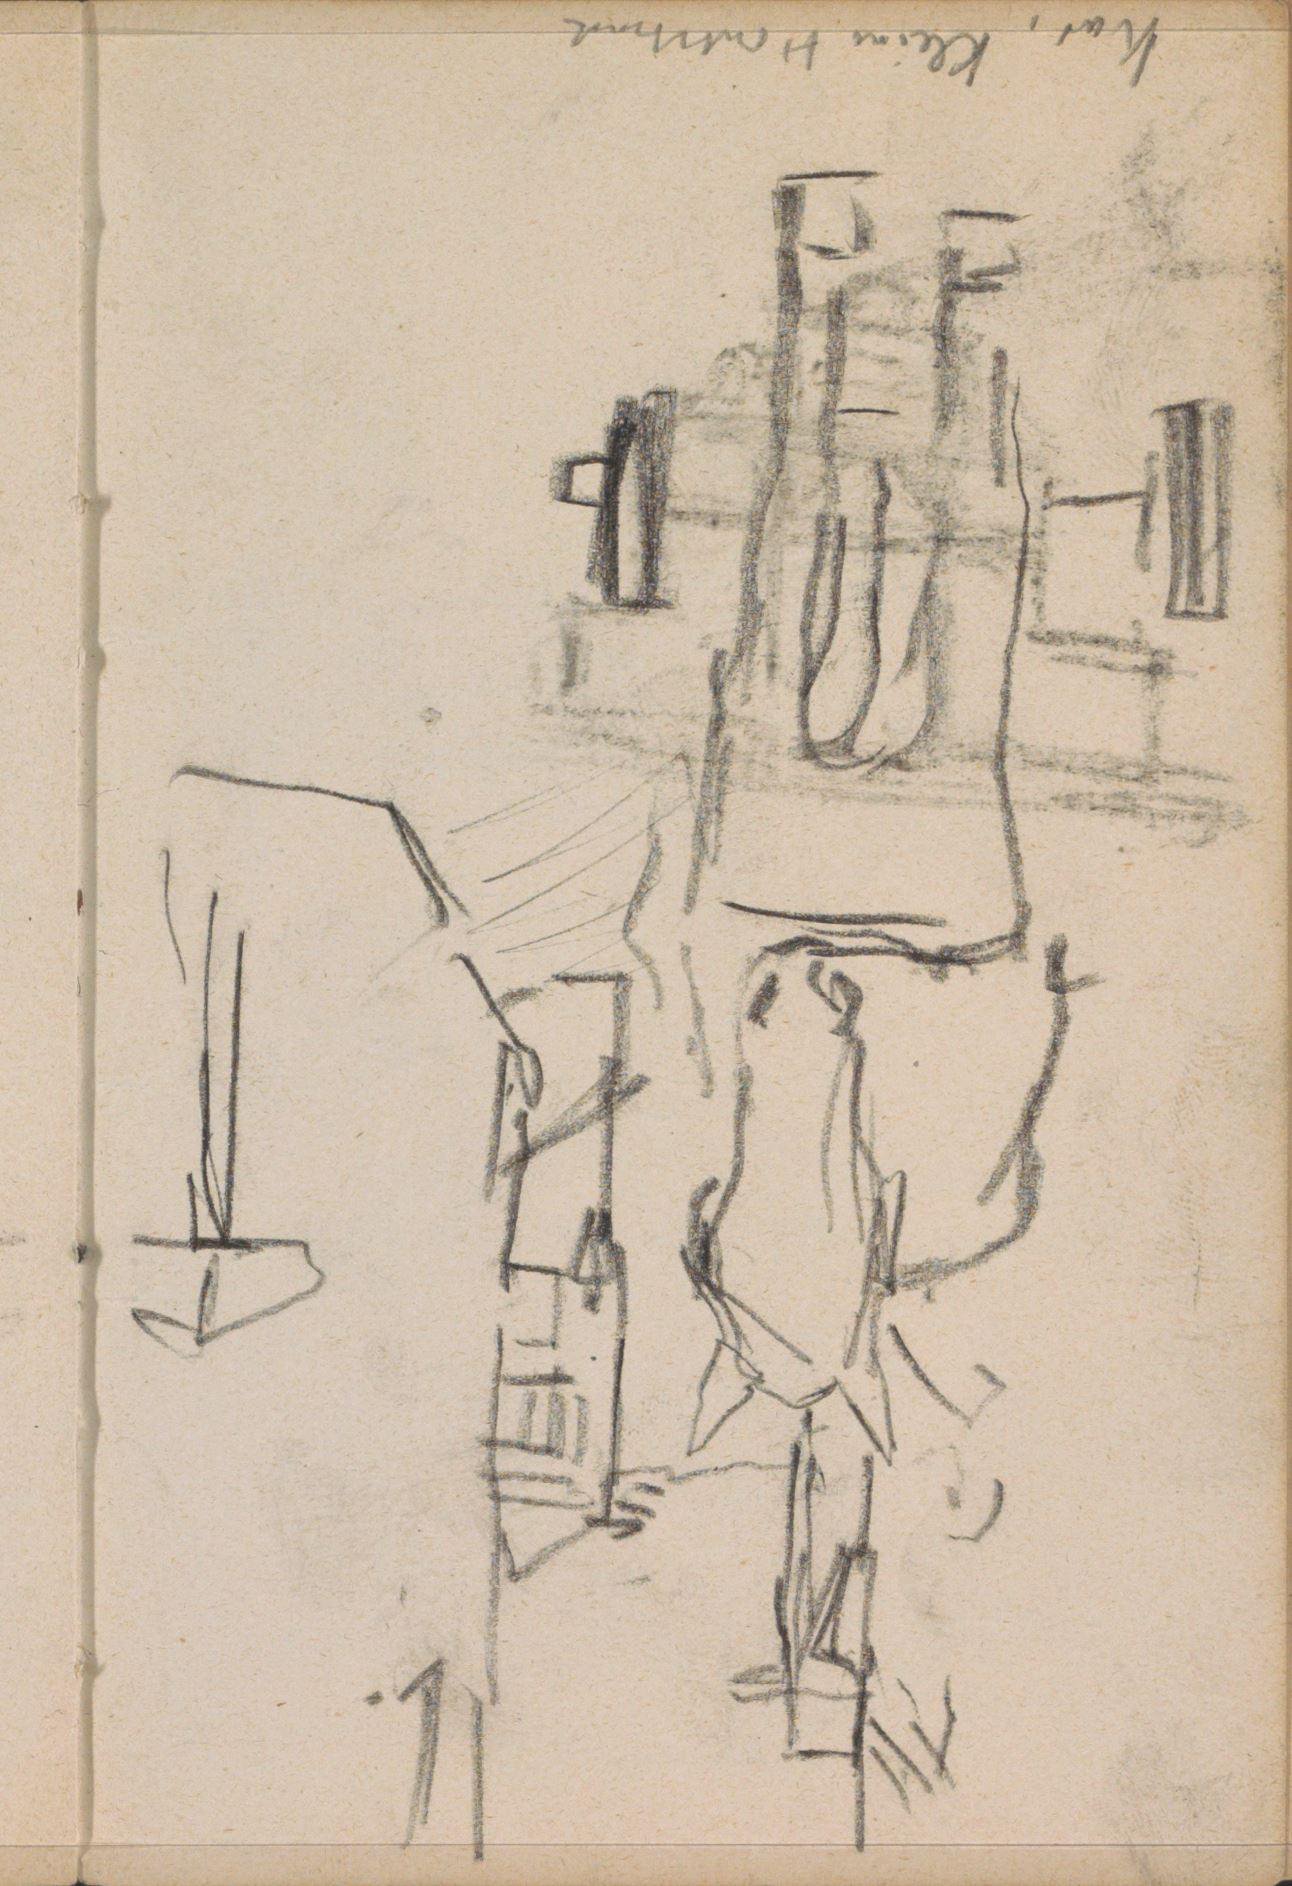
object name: sketchbook leaf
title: Paardenkar in de Kleine Houtstraat te Amsterdam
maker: george hendrik breitner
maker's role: draughtsman, painter, print maker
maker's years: 1857-1923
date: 1902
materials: chalk, paper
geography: amsterdam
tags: horse, street, (farm) wagon, freight wagon, cart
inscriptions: annotation: ‘Kar, Kleine Houtstraat’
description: Pagina 20 uit een schetsboek met 46 bladen vervaardigd in de omgeving van Amsterdam, Rotterdam en Haarlem.